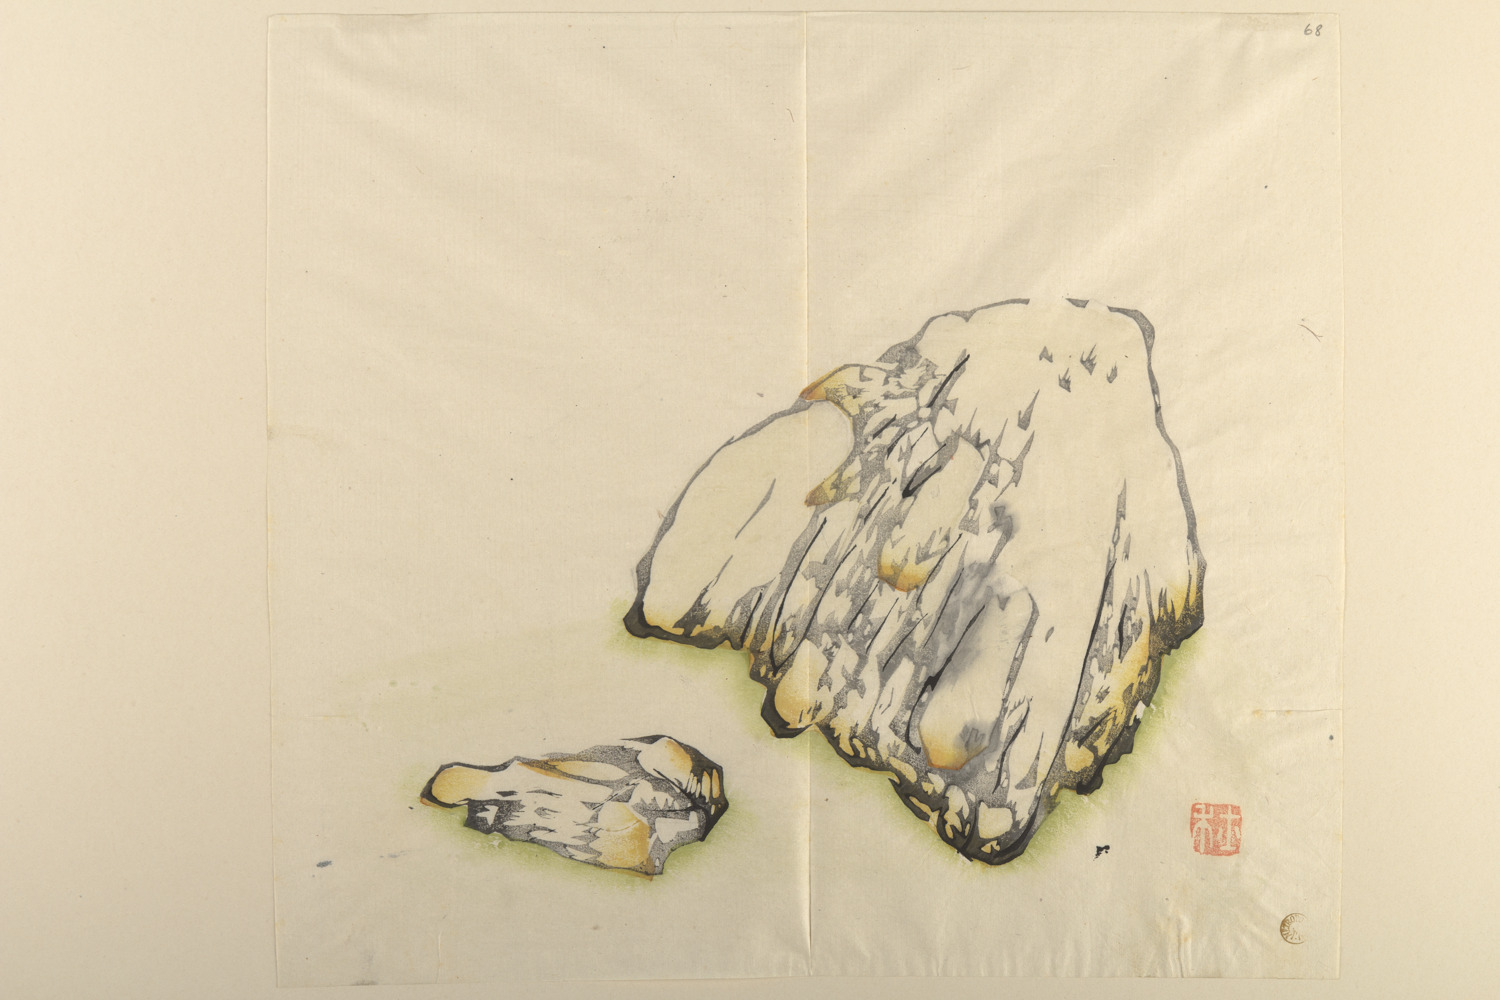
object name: print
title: Page from Shi Zhu Zhai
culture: chinese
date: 1736-1795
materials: ink, paper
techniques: polychrome, woodblock print